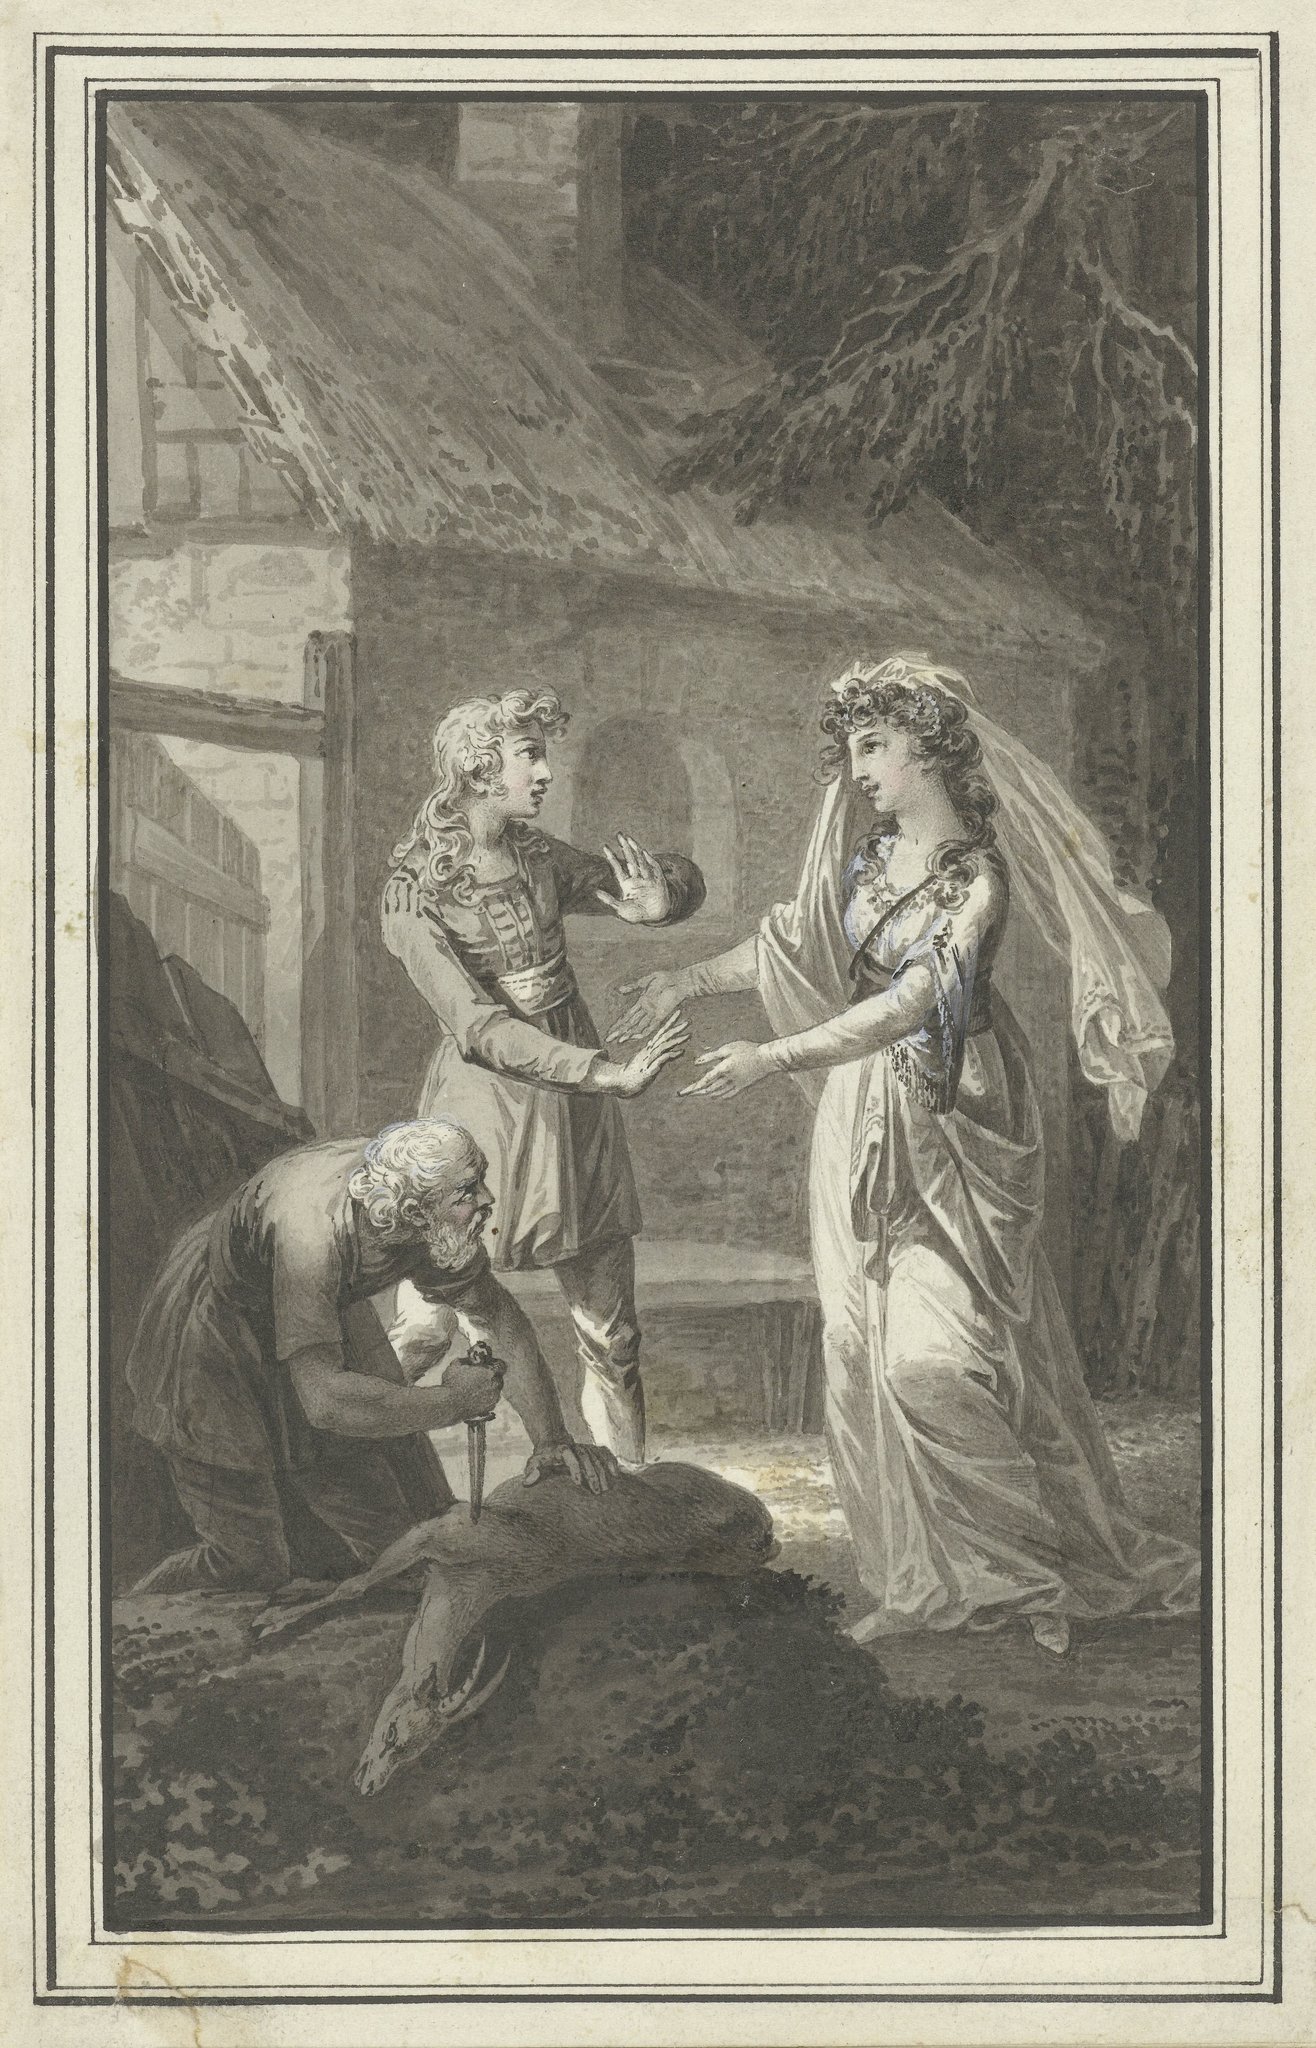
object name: drawing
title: Jong paar en oude man met dode bok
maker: Anonymous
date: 1700-1800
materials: ink, paper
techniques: brush, pen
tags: specific works of literature